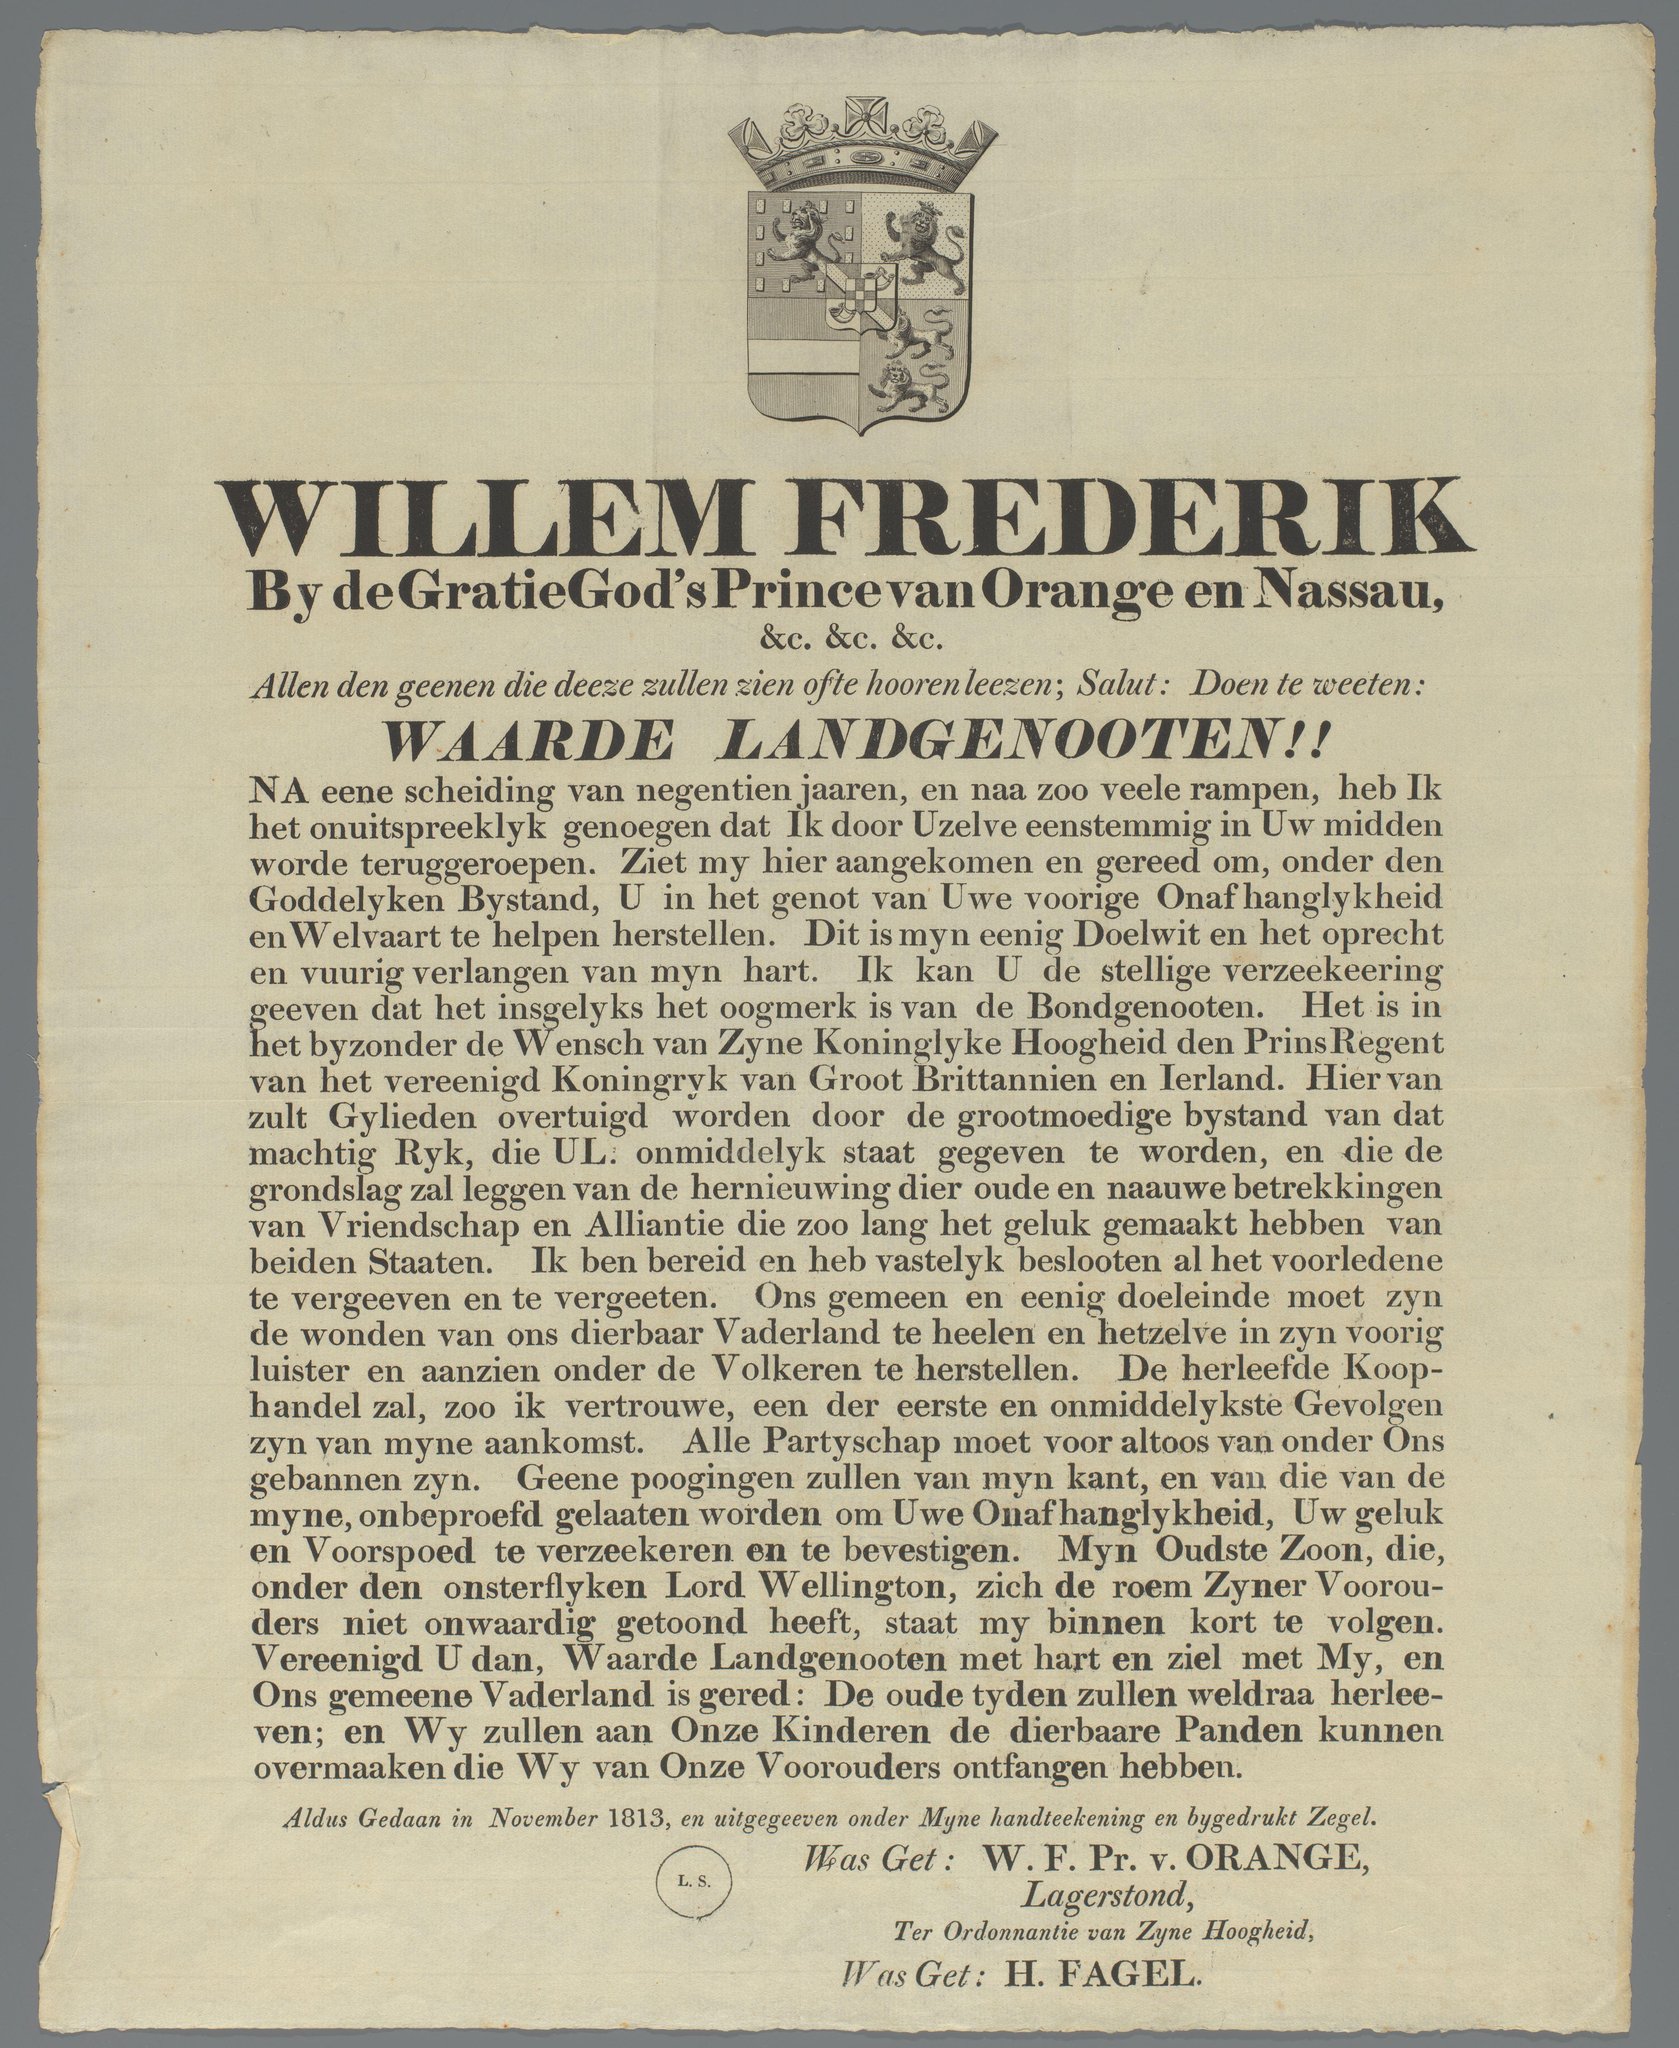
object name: printed matter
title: Terugkeer prins van Oranje (later Koning Willem I) in Nederland, 1813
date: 1811-1813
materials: paper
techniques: printing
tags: the hague, william i of the netherlands, netherlands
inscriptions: date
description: Proclamatie, waarin Willem Frederik, prins van Oranje-Nassau, het volk van Nederland meedeelt in Nederland te zijn teruggekeerd. Gedateerd; l.o.: nov. 1813.